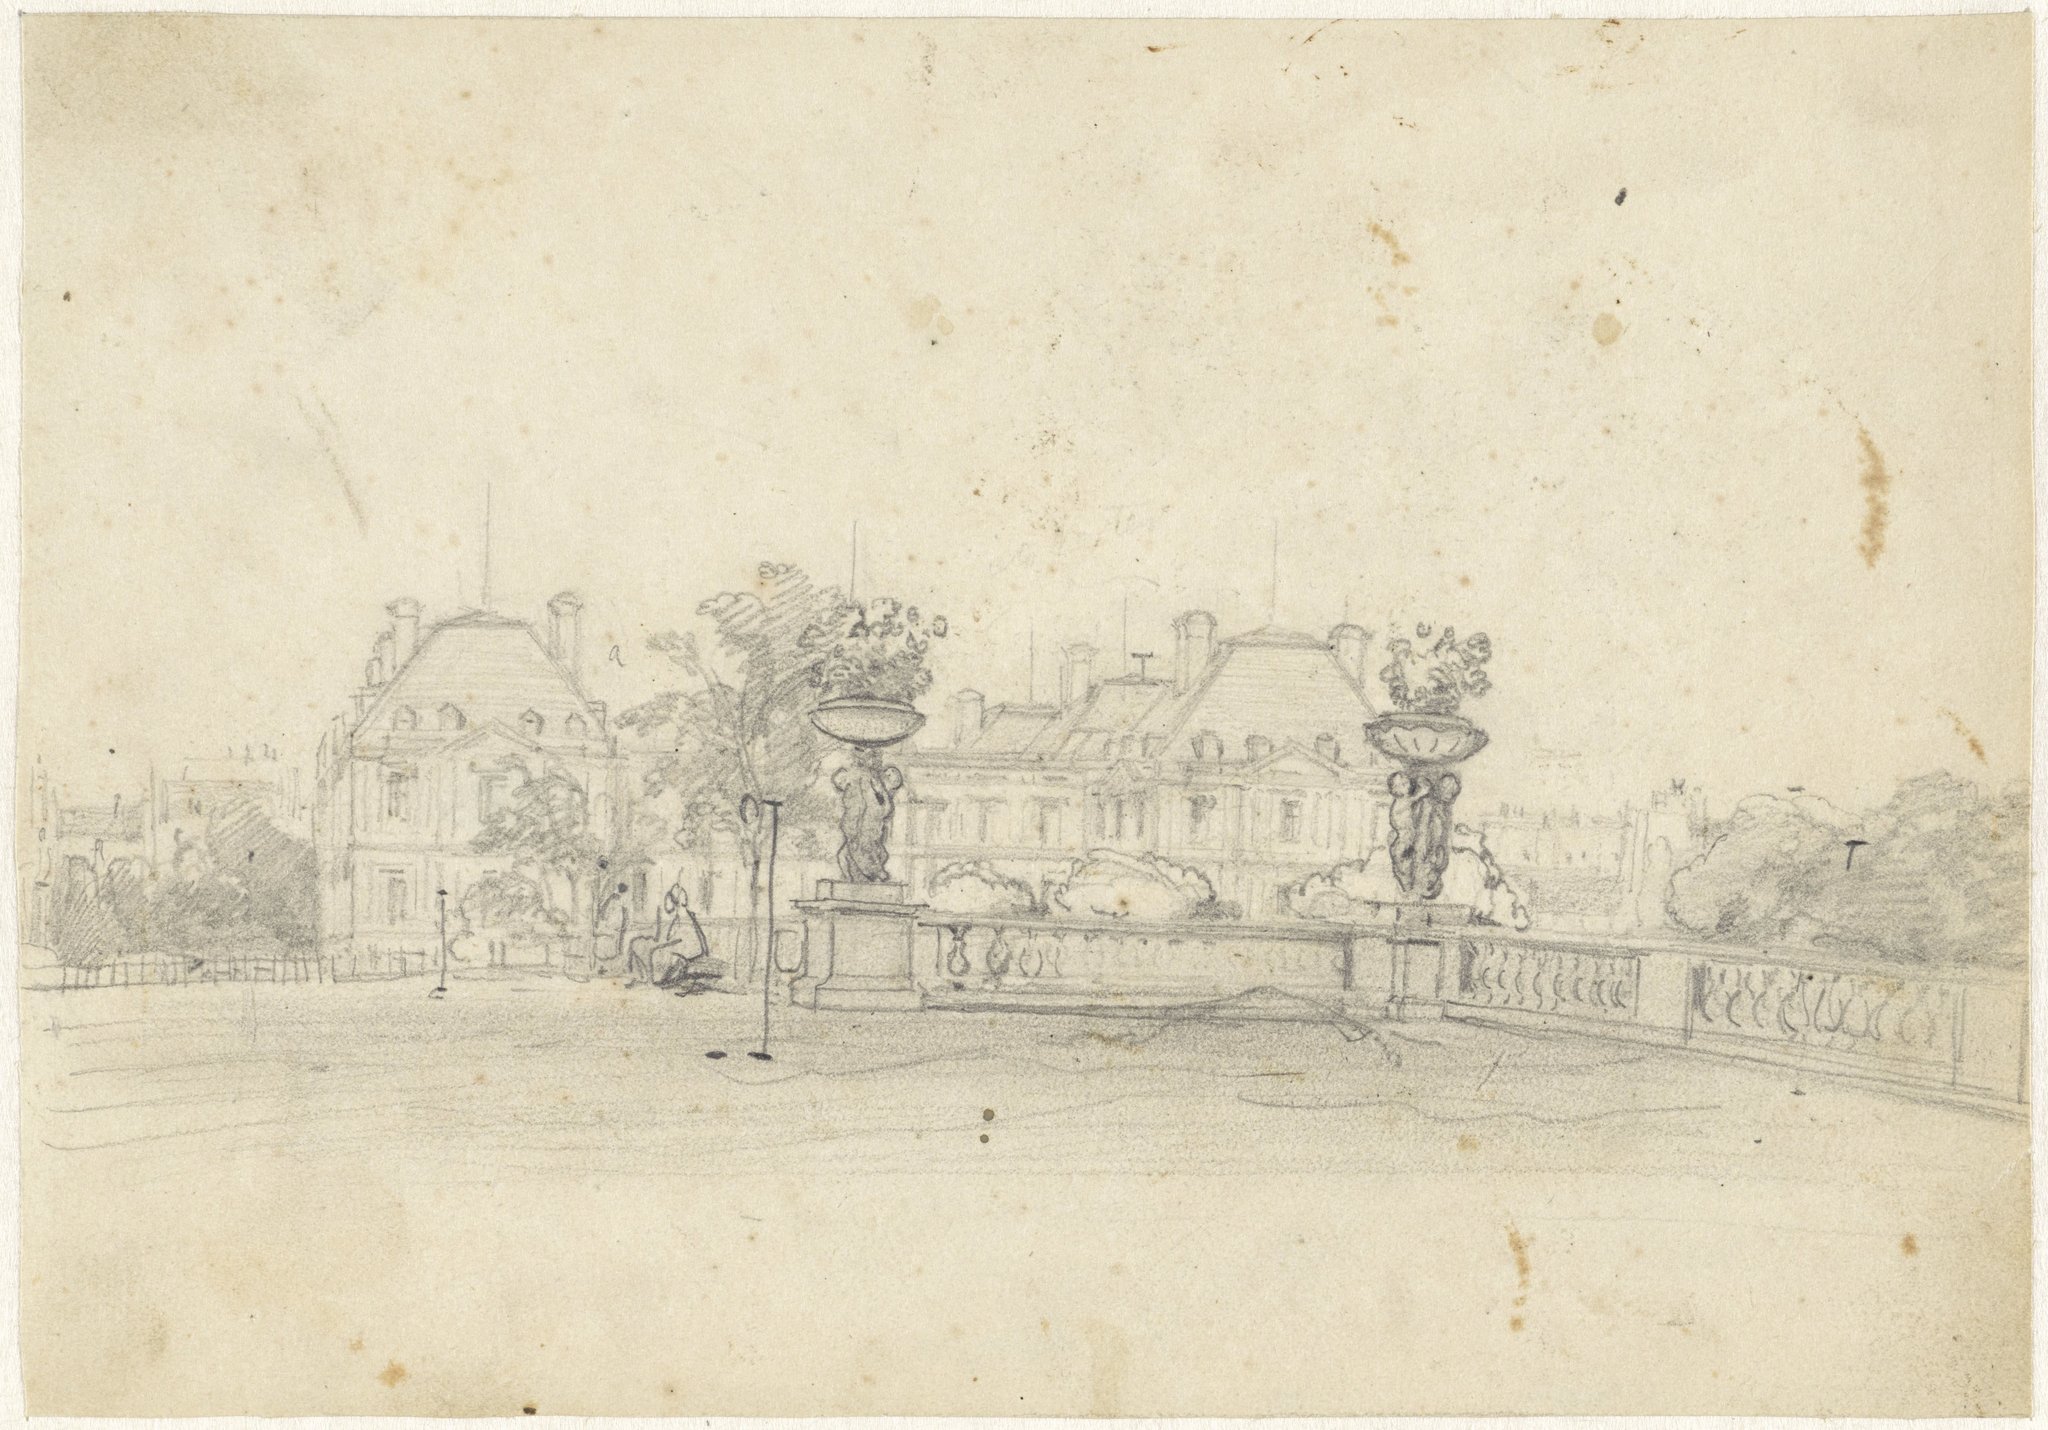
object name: drawing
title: Het Luxembourg te Parijs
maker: charles rochussen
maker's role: draughtsman, painter, print maker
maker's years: 1814-1894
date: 1824-1894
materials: paper, pencil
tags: civic architecture; edifices; dwellings, paris